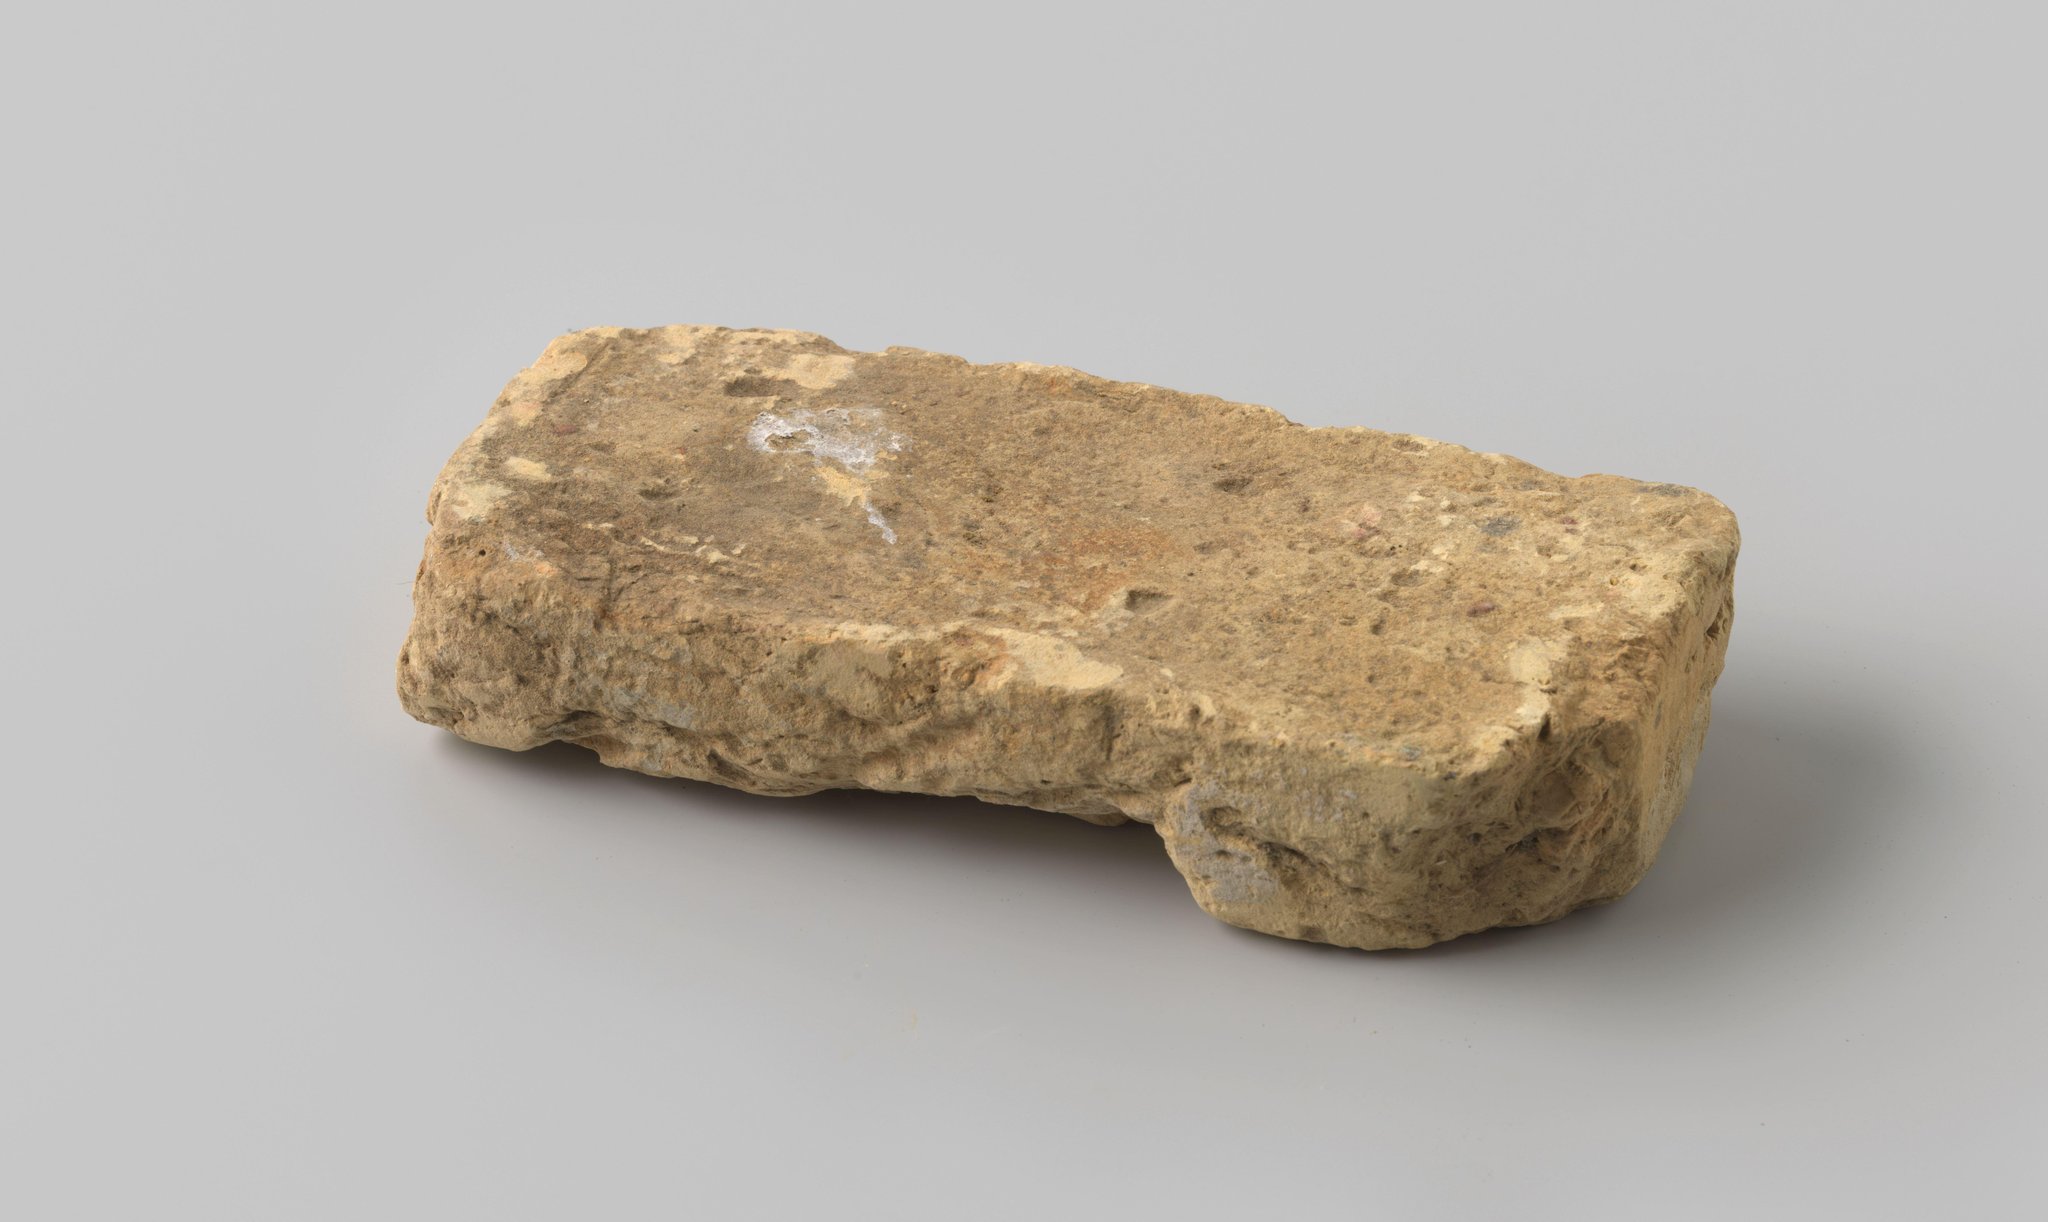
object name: brick clay product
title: Baksteen uit het wrak van de Oost-Indiëvaarder Hollandia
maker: Anonymous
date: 1700-1743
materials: brick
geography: netherlands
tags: verenigde oostindische compagnie, hollandia (schip), annet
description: Constructional elements, brick; sim. 80H2567, sim. 80H1208, sim. 80H1009.